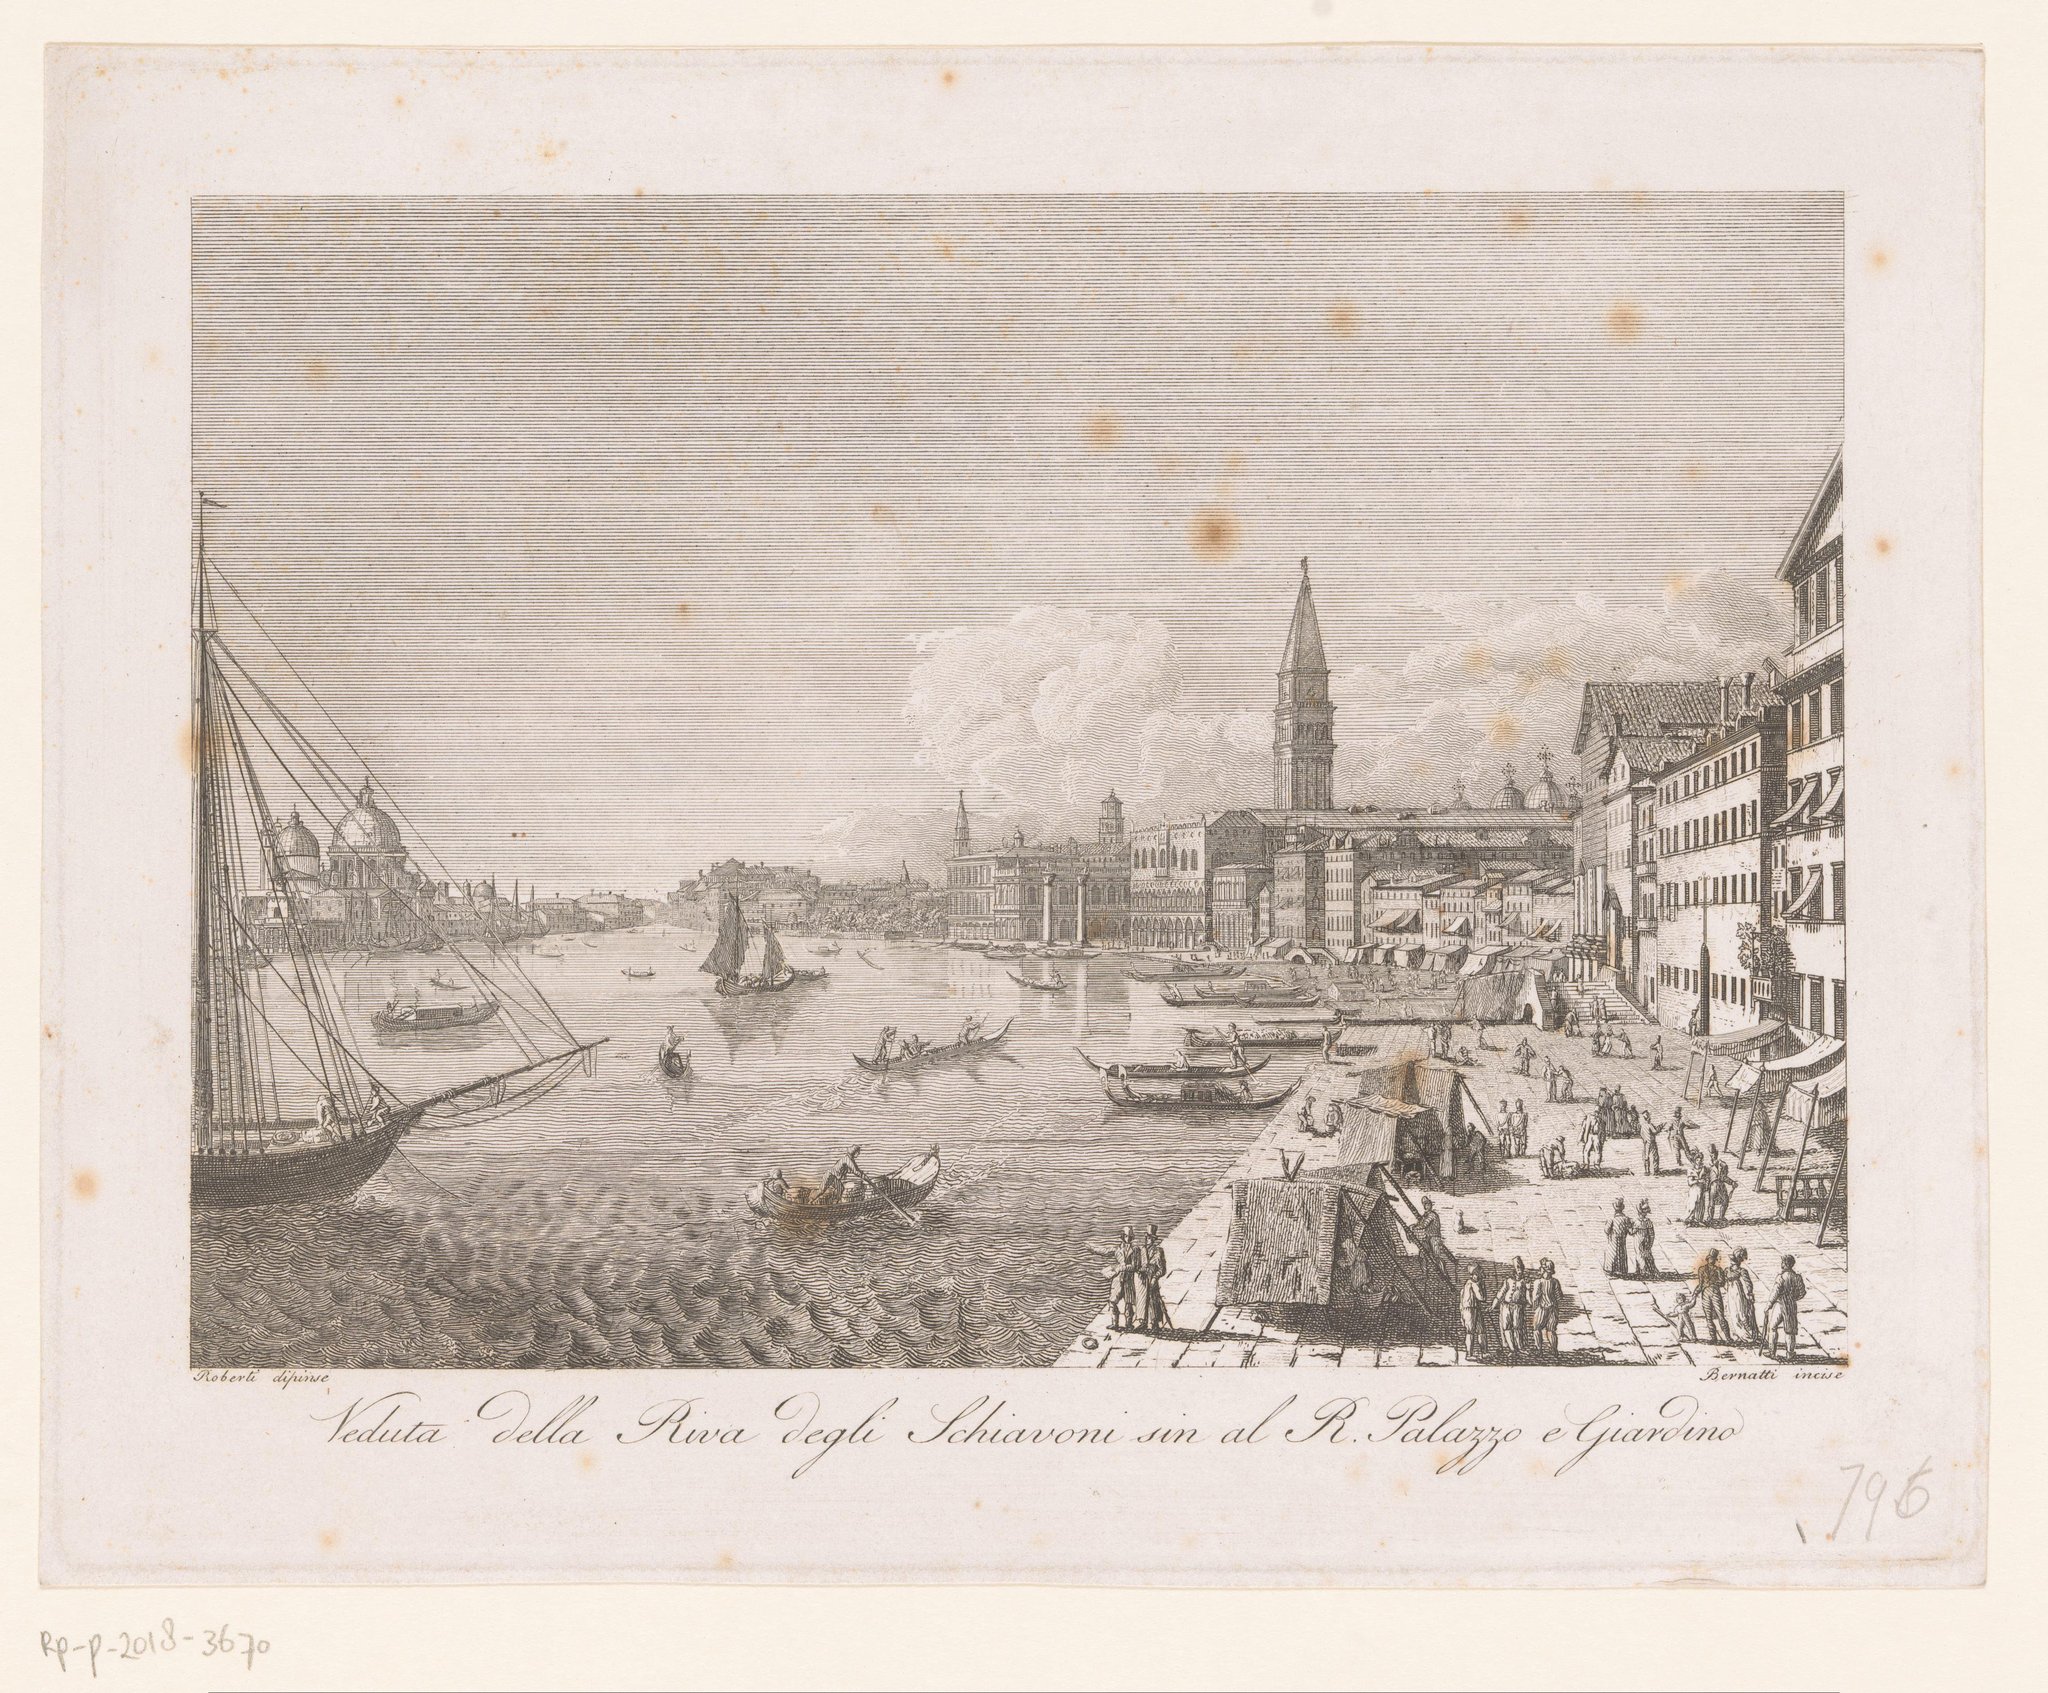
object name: print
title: Veduta della Riva degli Schiavoni sin al R. Palazzo e Giardino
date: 1802-1837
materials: paper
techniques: etching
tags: canals, waters (in city), quay